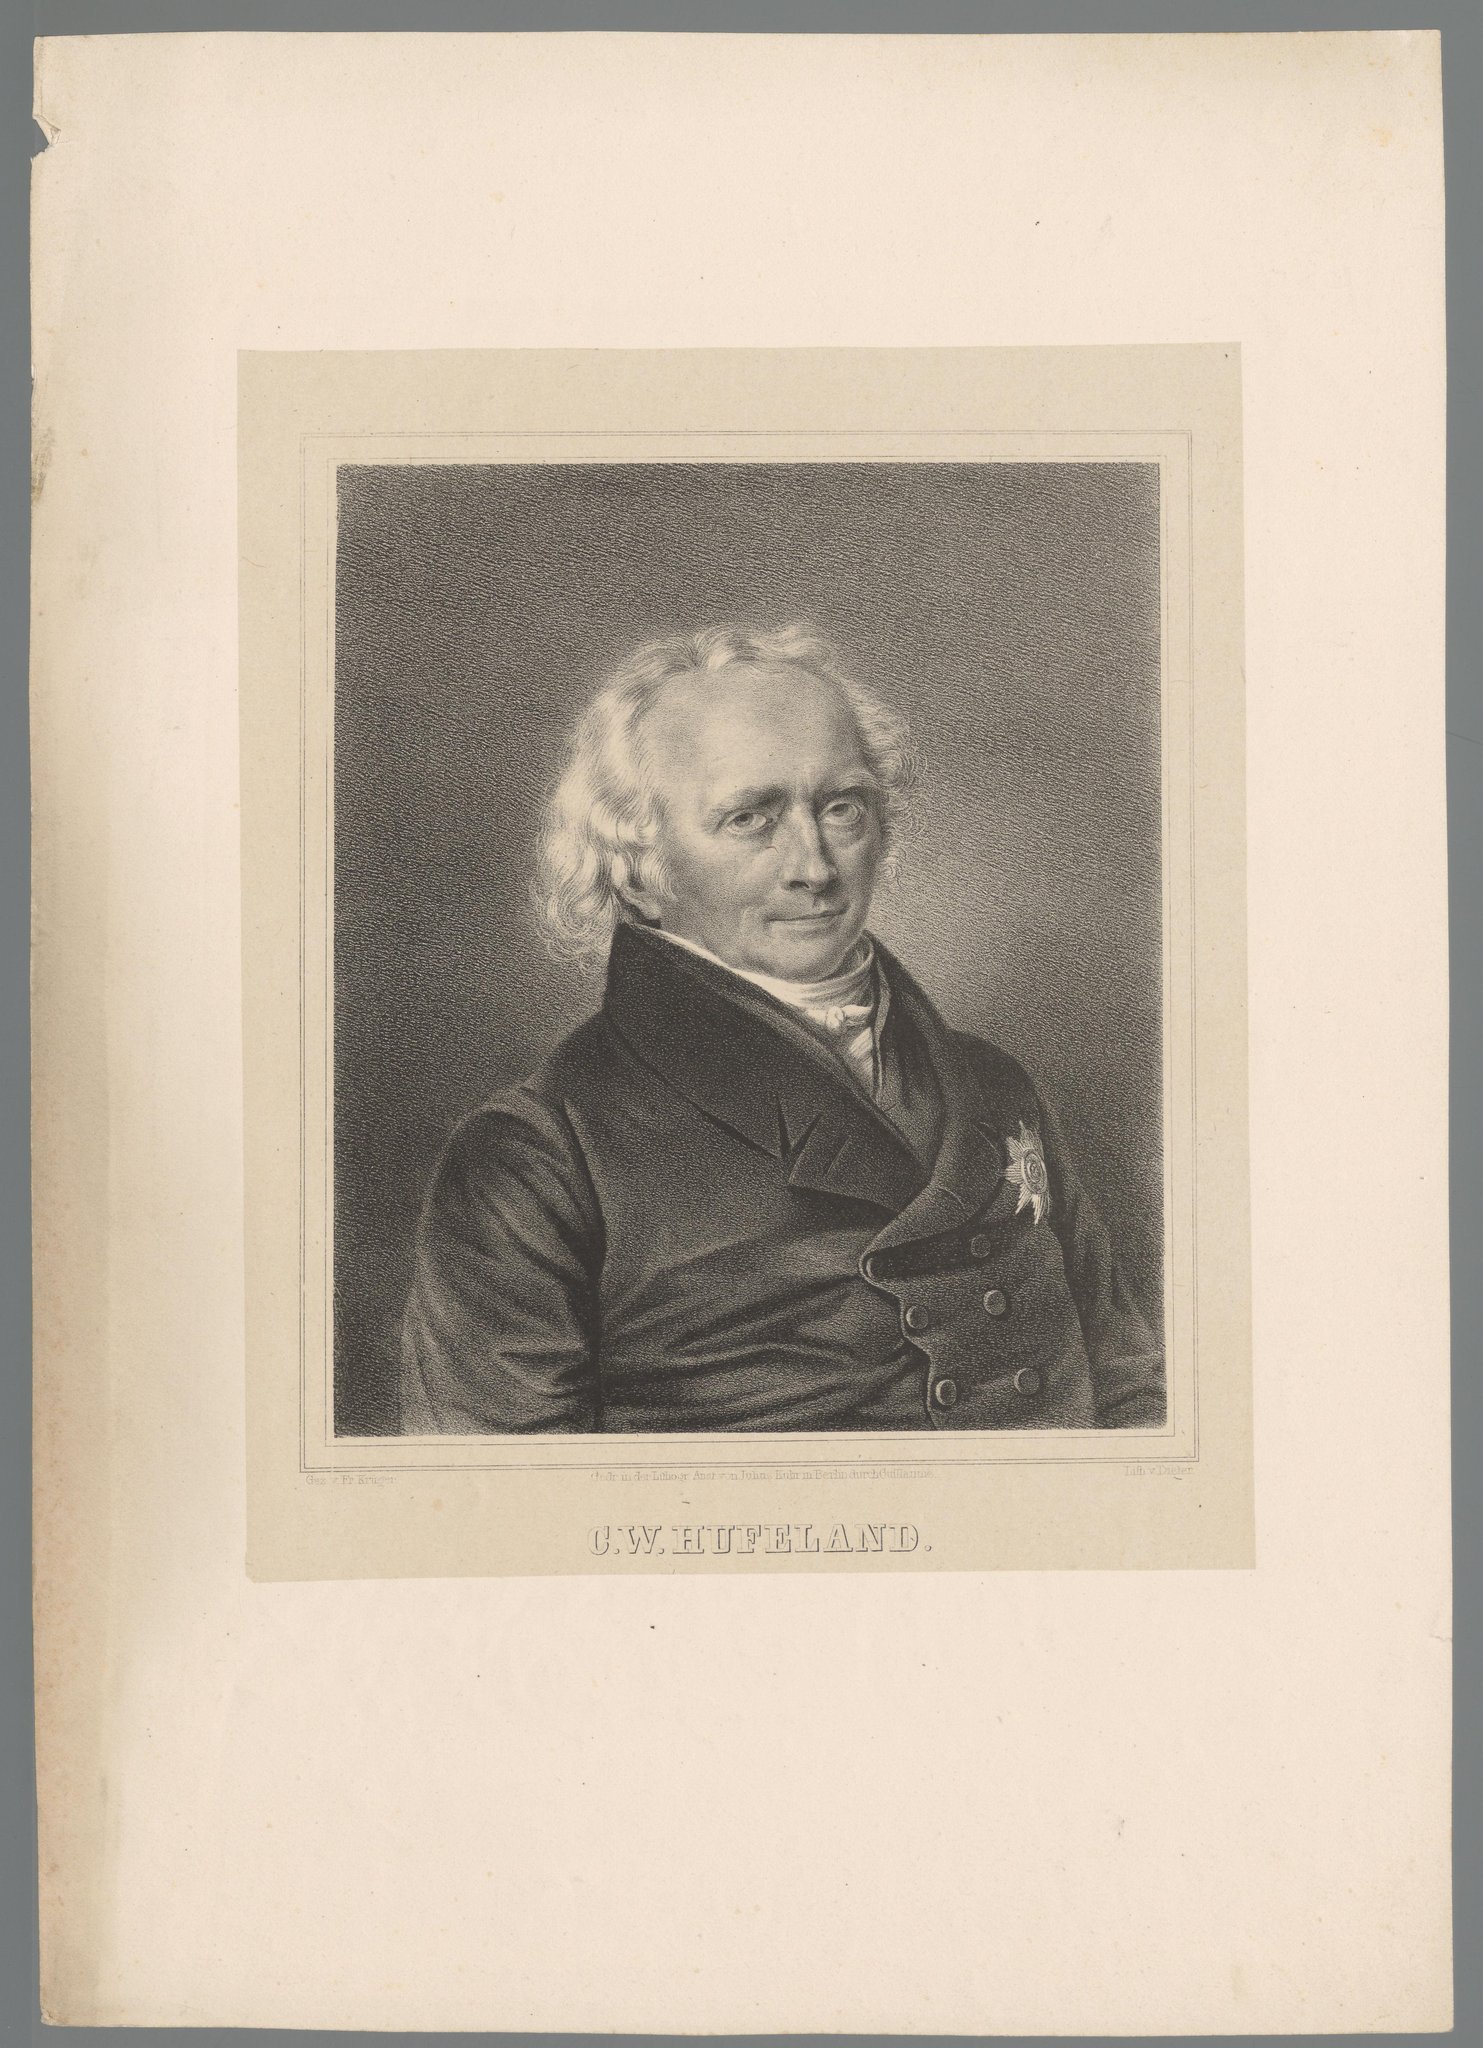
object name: print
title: Portret van Christoph Wilhelm von Hufeland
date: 1820-1850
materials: paper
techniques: lithograph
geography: berlin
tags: berlin, historical persons, physician, doctor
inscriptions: collector's mark: Lugt 2228